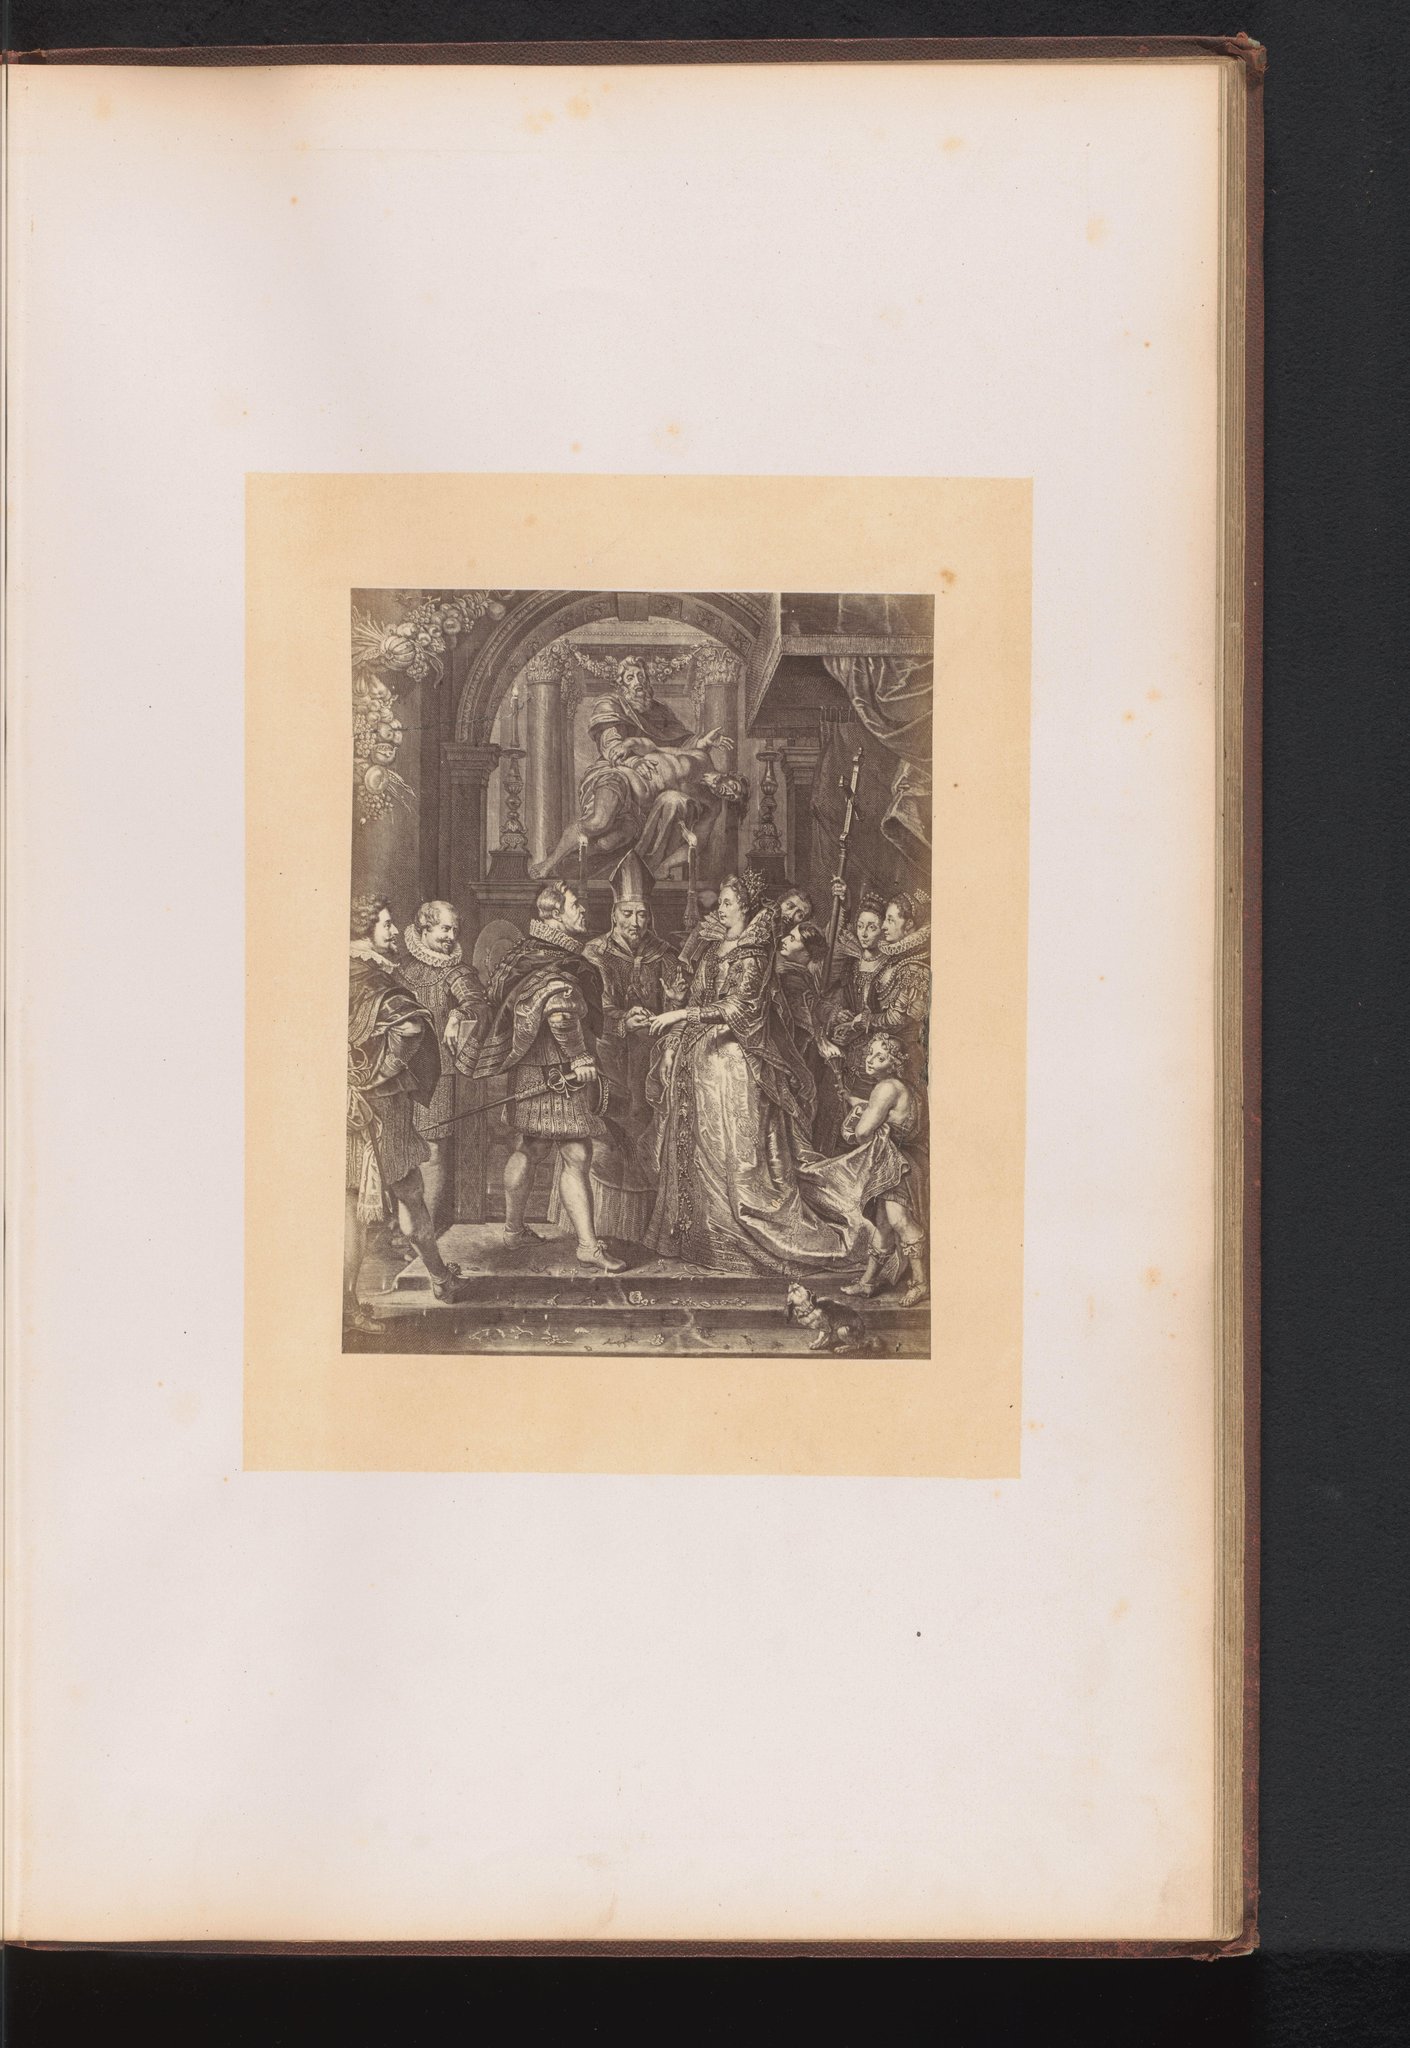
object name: page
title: Fotoreproductie van een gravure van Het huwelijk van Maria de'Medici met koning Hendrik IV door Jean-Marc Nattier, naar het schilderij door Peter Paul Rubens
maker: peter paul rubens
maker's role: draughtsman, painter, print maker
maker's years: 1577-1640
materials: photographic support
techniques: albumen print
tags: cologne, print maker, maria de' medici, paris, hendrik iv (koning van frankrijk en navarra), marriage, married couple, 'matrimonium', king